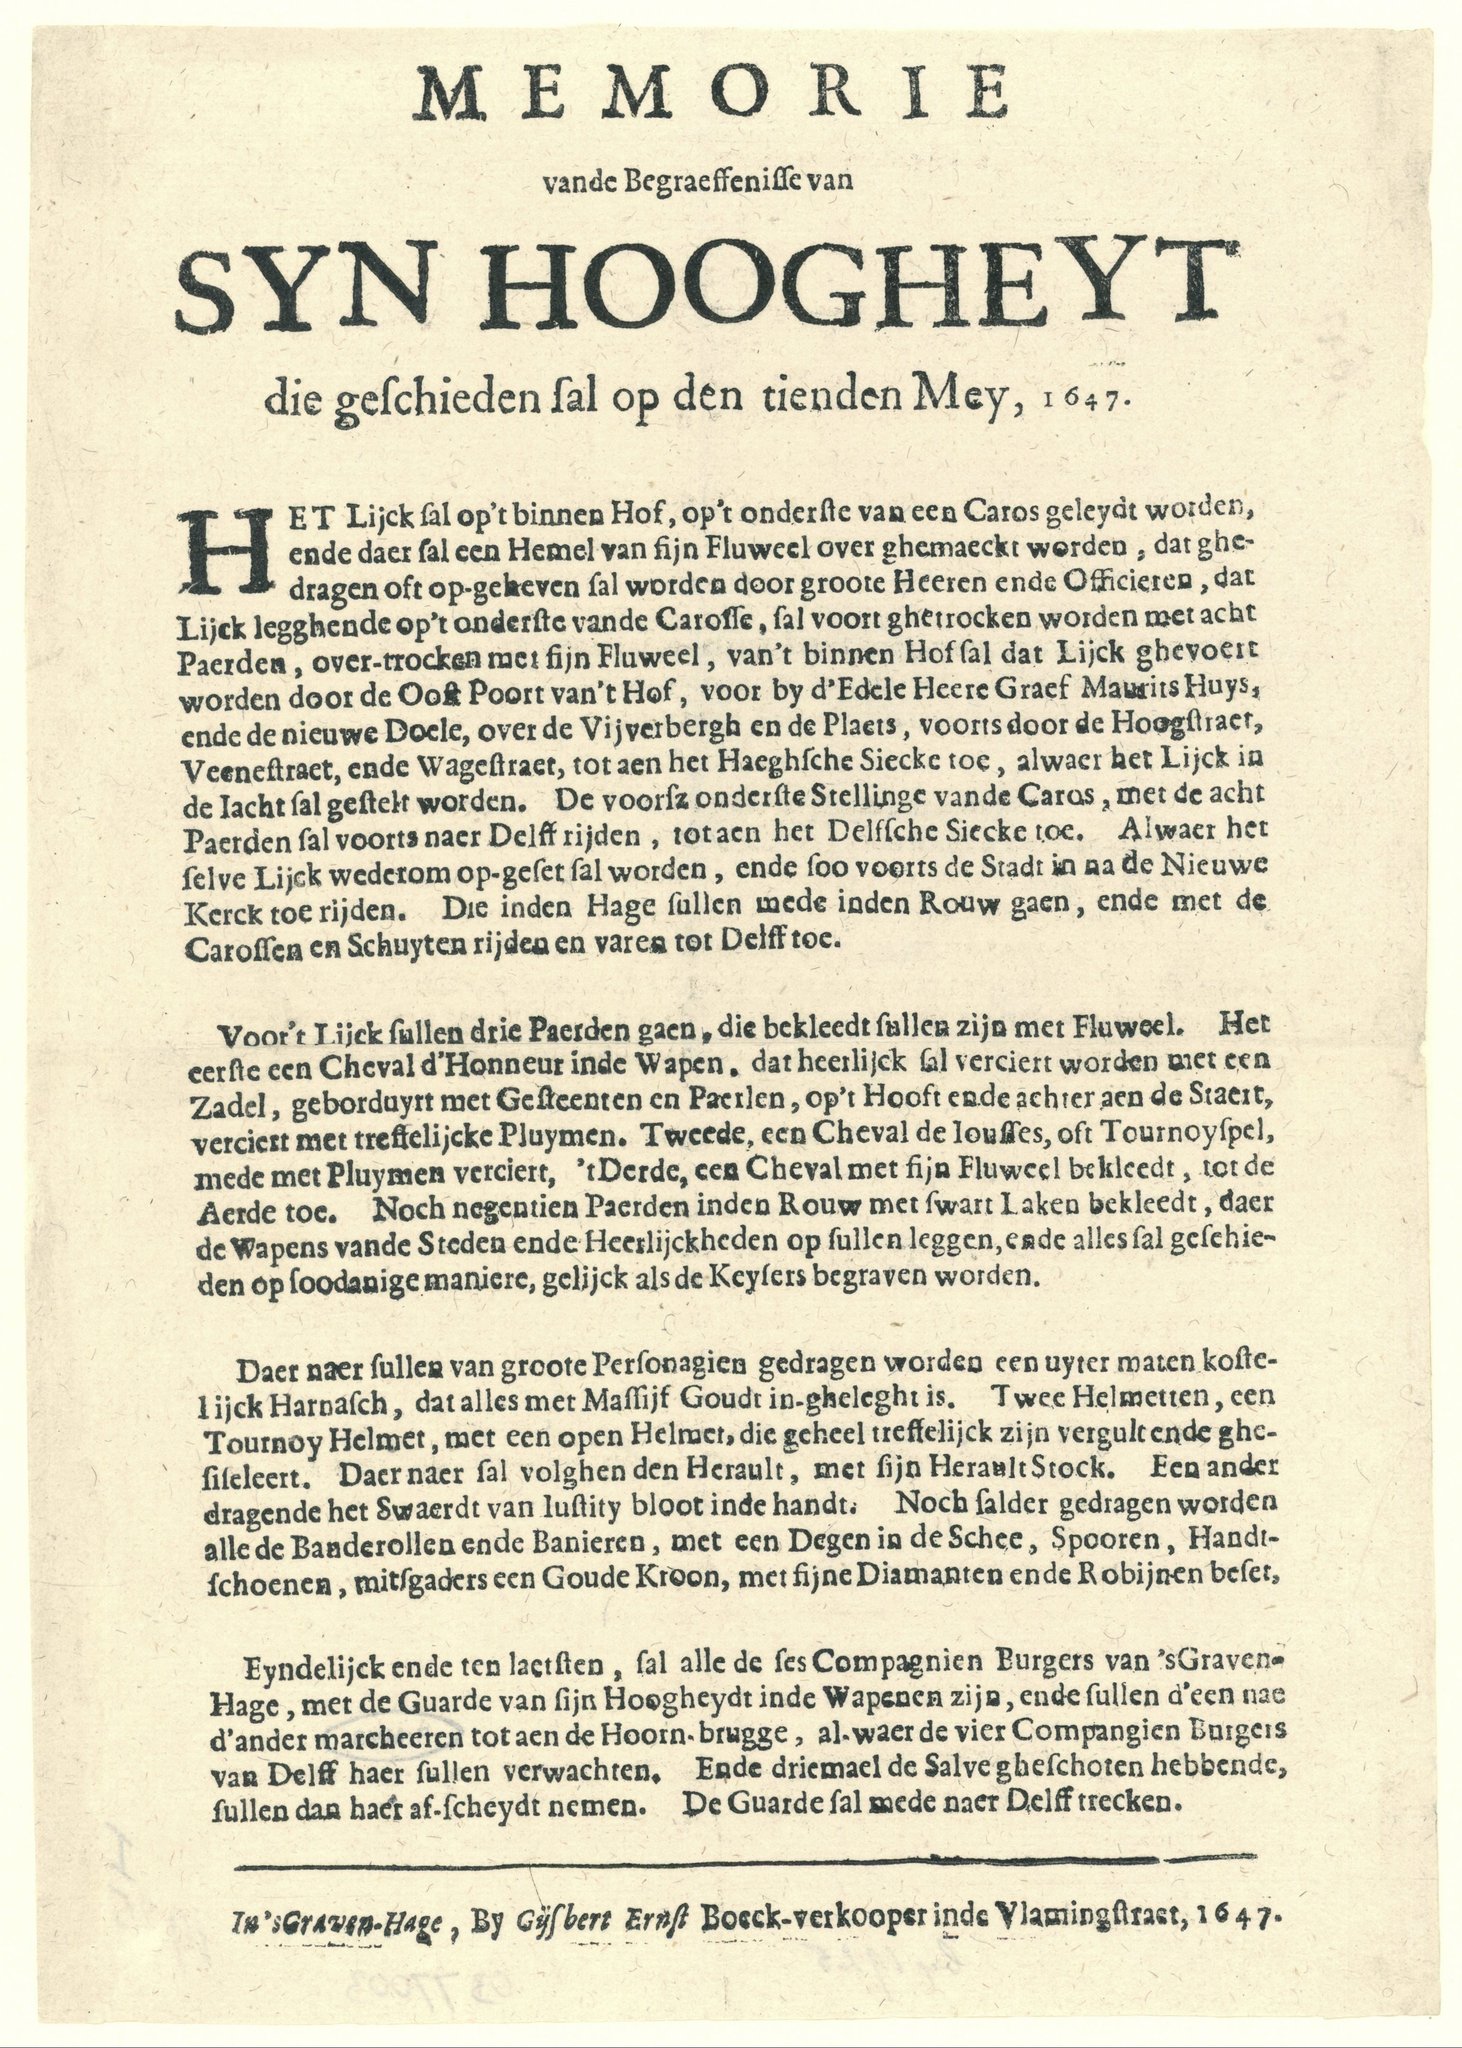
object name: text sheet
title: Memorie vande Begraeffenisse van Syn Hoogheyt die geschieden sal op den tienden Mey, 1647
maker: gijsbrecht ernst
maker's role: publisher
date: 1647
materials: paper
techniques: letterpress printing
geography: the hague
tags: delft, the hague, frederick henry (prince of orange)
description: Blad met een gedrukte tekst in één kolom over de samenstelling van de lijkstatie van Frederik Hendrik die op 10 mei 1647 te 's-Gravenhage gehouden zal worden.